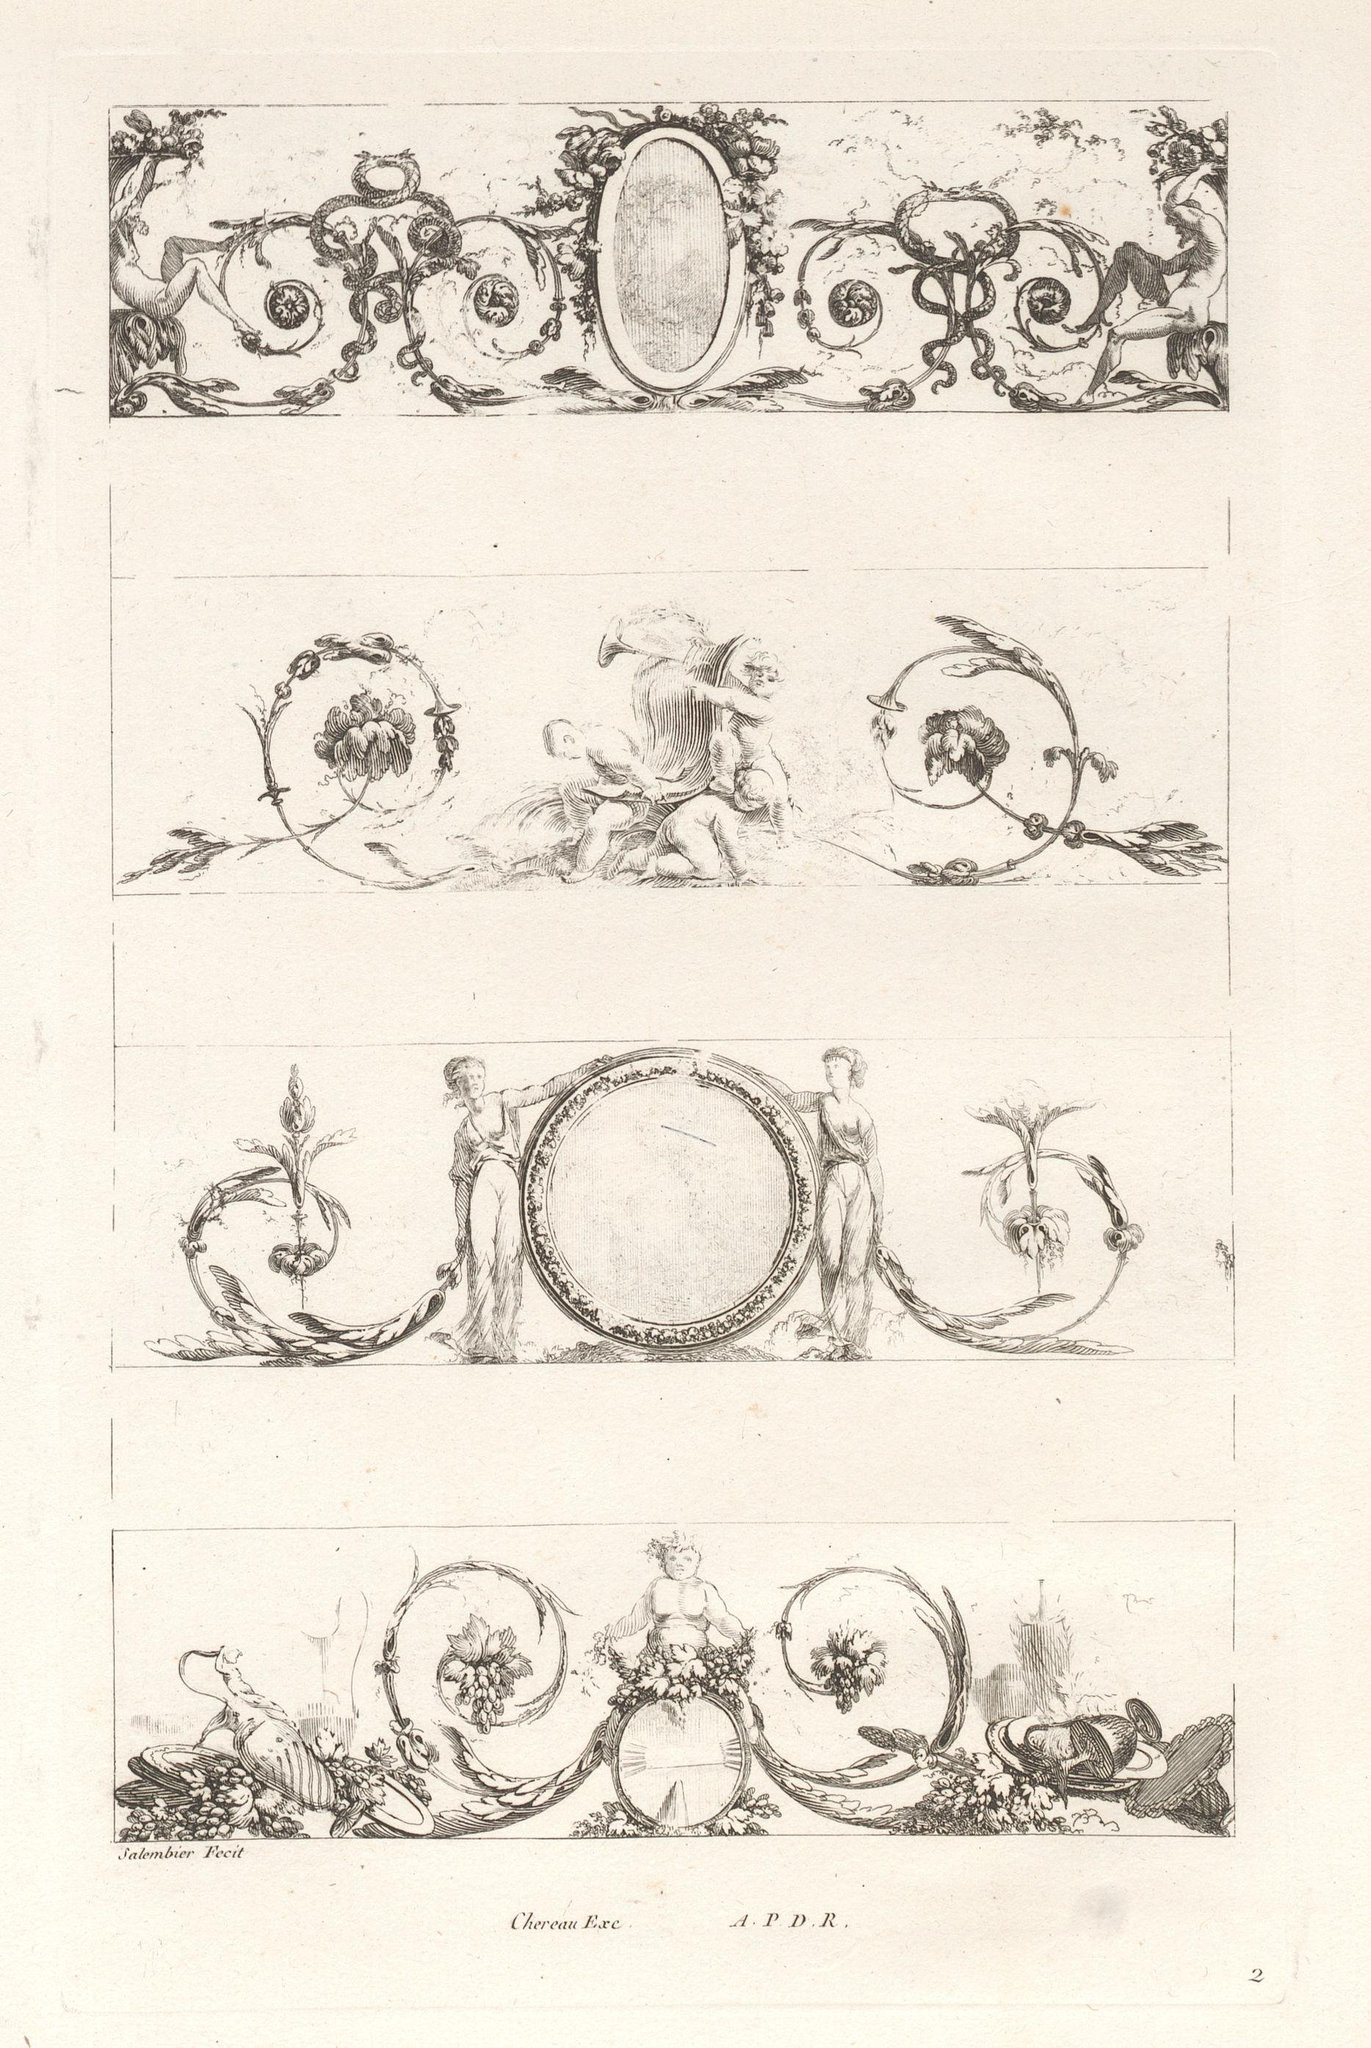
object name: ornament print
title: Ontwerp voor vier ornamentele friezen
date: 1802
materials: paper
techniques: etching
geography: paris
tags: attributes of bacchus, ornament ~ arabesque, cupids: 'amores', 'amoretti', 'putti', ornament derived from plant forms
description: Doordat dit album bestaat uit meerdere, deels eerder uitgegeven prentreeksen, is de datering niet consequent. Het geheel is op de titelpagina gedateerd op 1802. Deze reeks is niet afzonderlijk gedateerd. De serietitel voor het gehele werk is "Recueil d'arabesques, contenant les loges du Vatican". De andere serietitel is de titel van de specifieke reeks binnen het geheel.